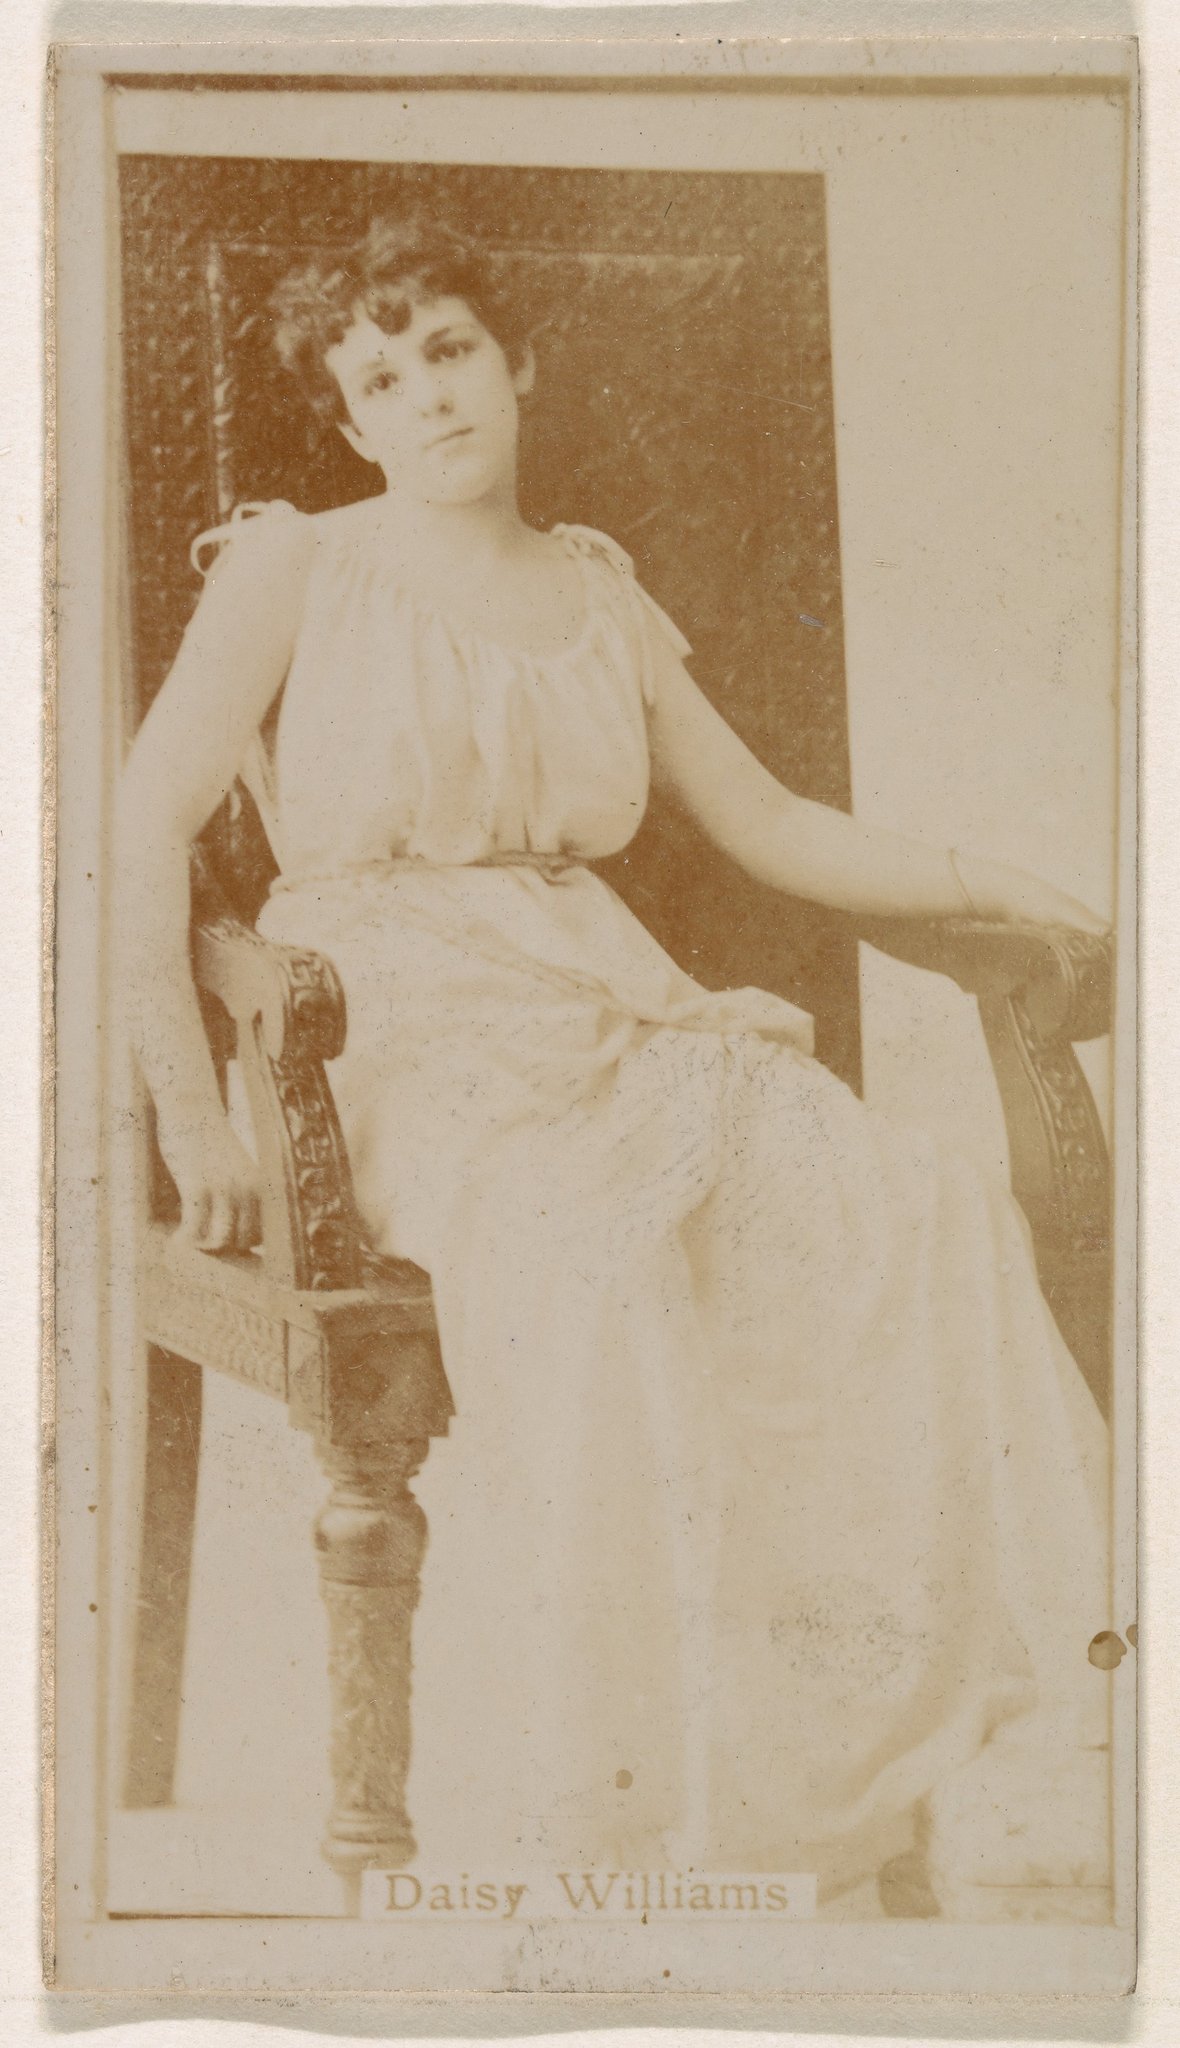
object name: photograph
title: Daisy Williams, from the Actresses series (N245) issued by Kinney Brothers to promote Sweet Caporal Cigarettes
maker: kinney brothers tobacco company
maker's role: publisher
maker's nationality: american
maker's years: 1869-2011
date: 1890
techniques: albumen silver print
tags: portraits,women,actresses